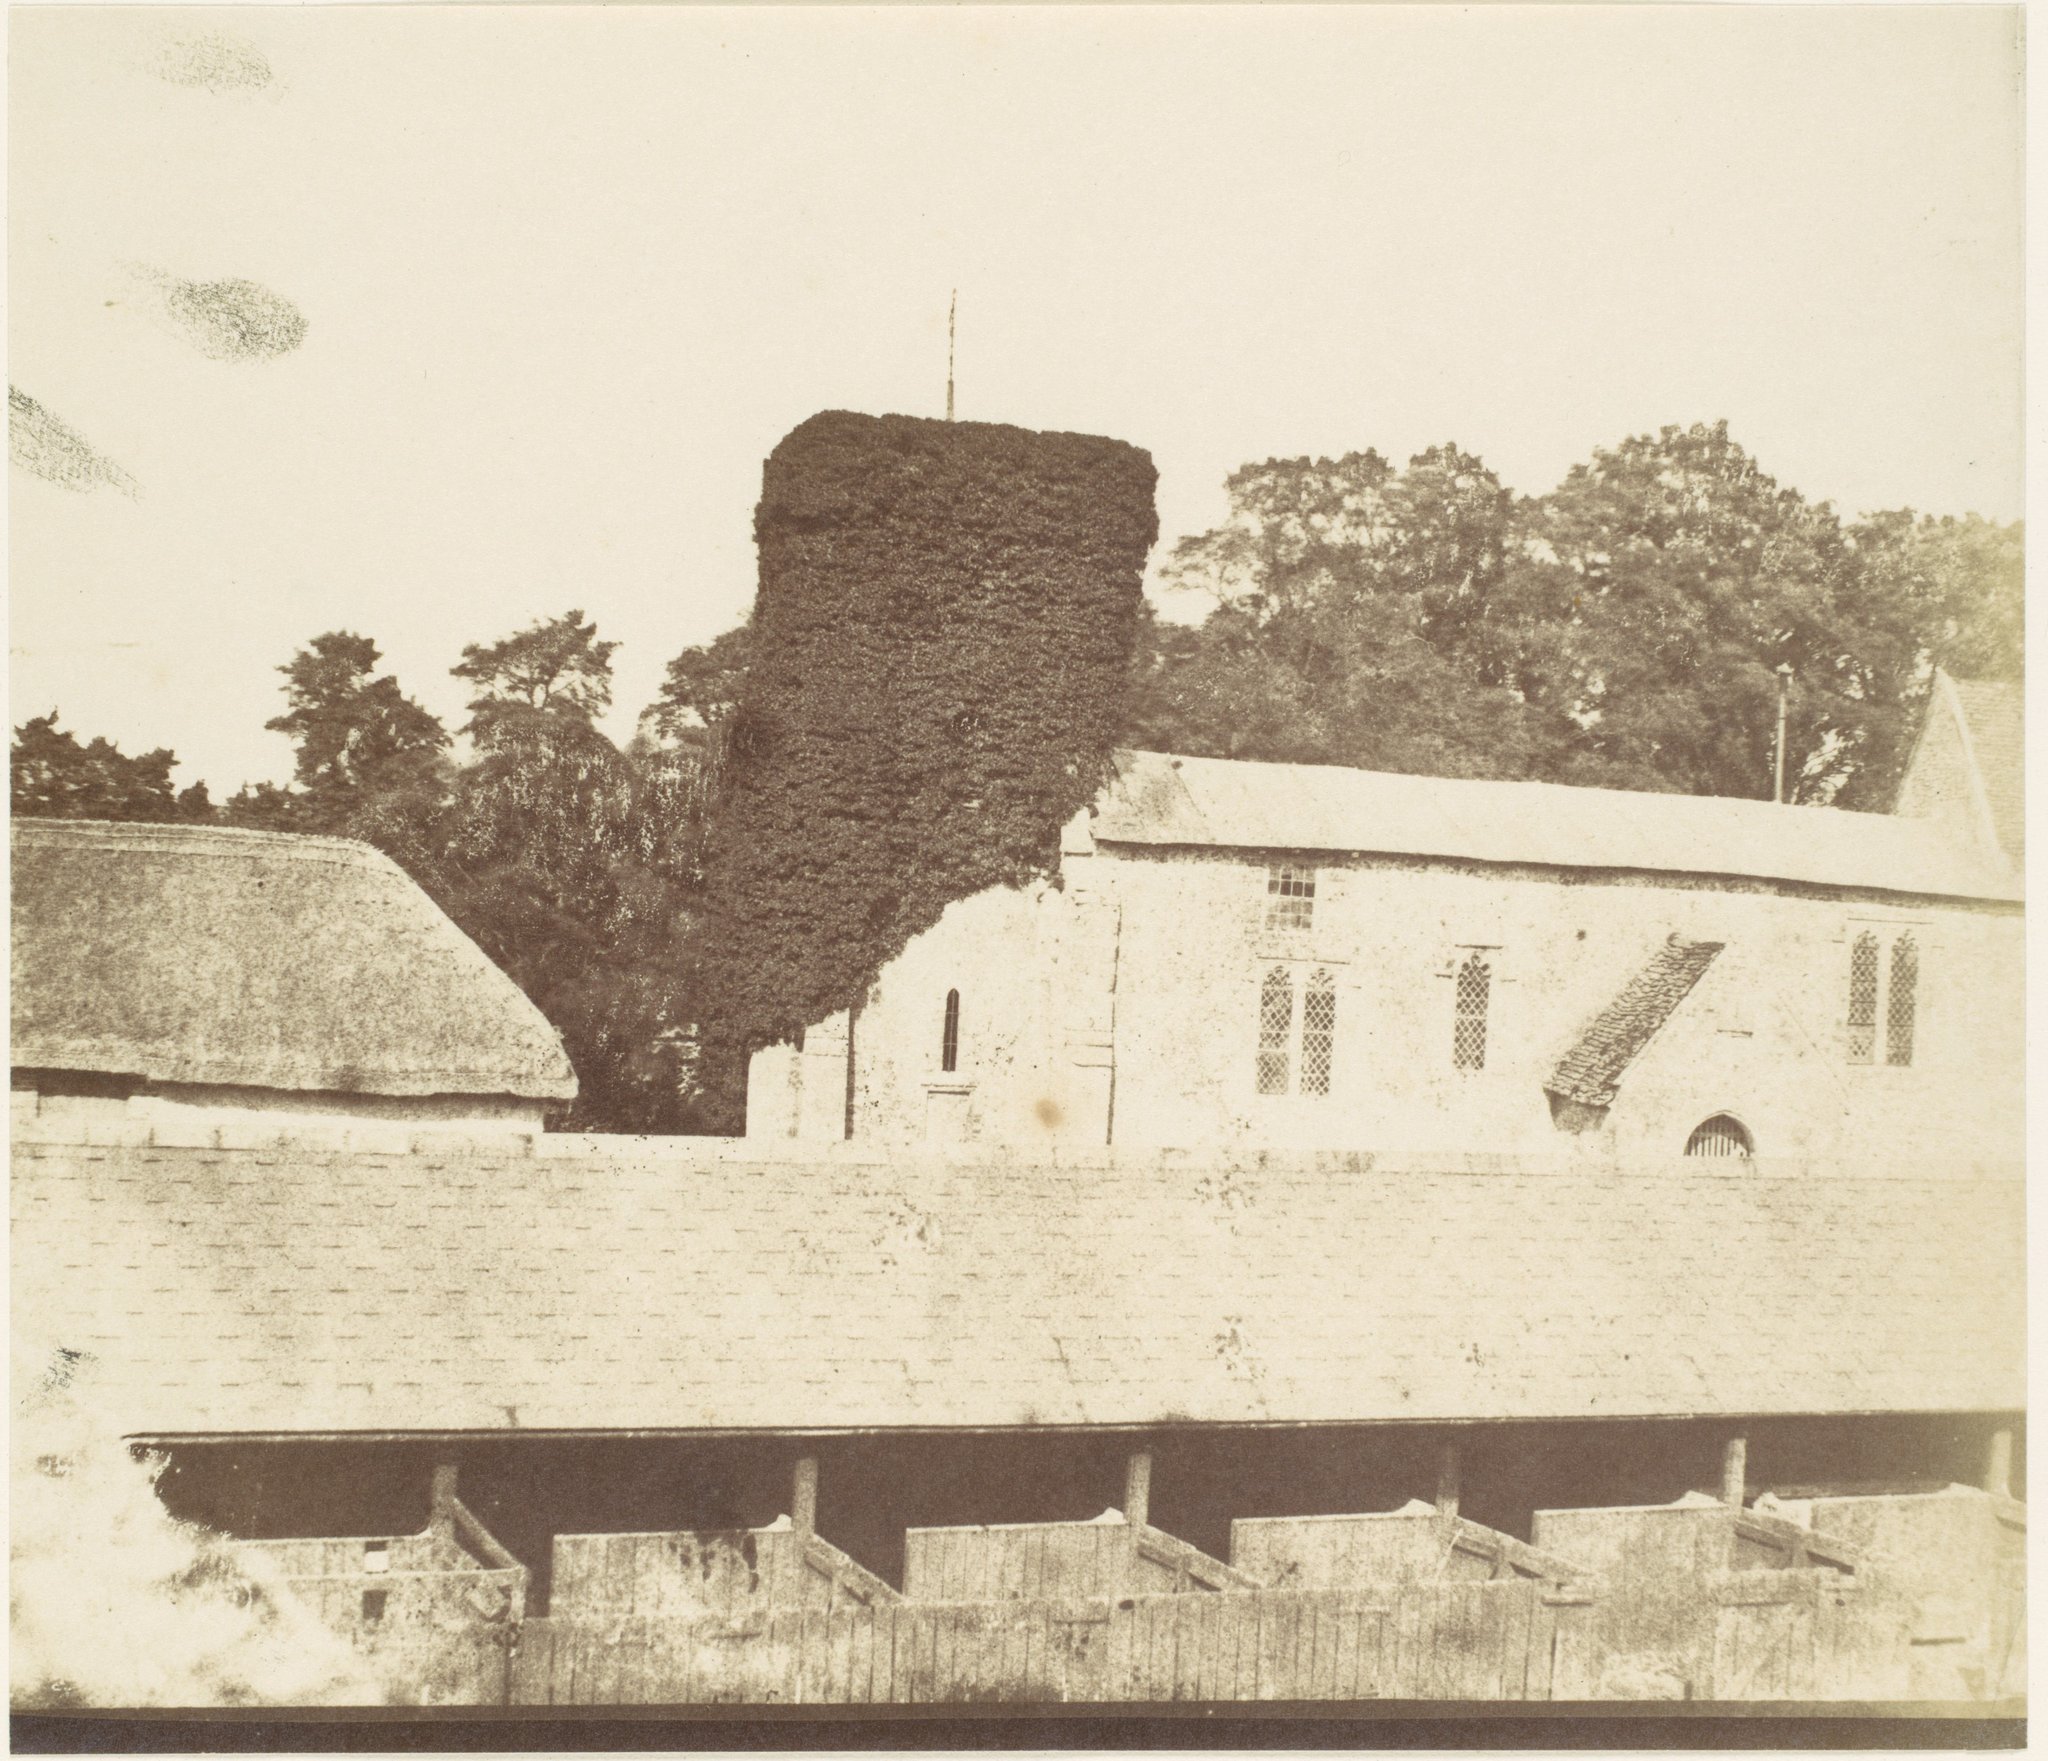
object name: photograph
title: [Stables and Ivy Covered Tower]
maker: Anonymous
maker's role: artist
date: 1850-1859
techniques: paper negative, salted paper print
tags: architecture